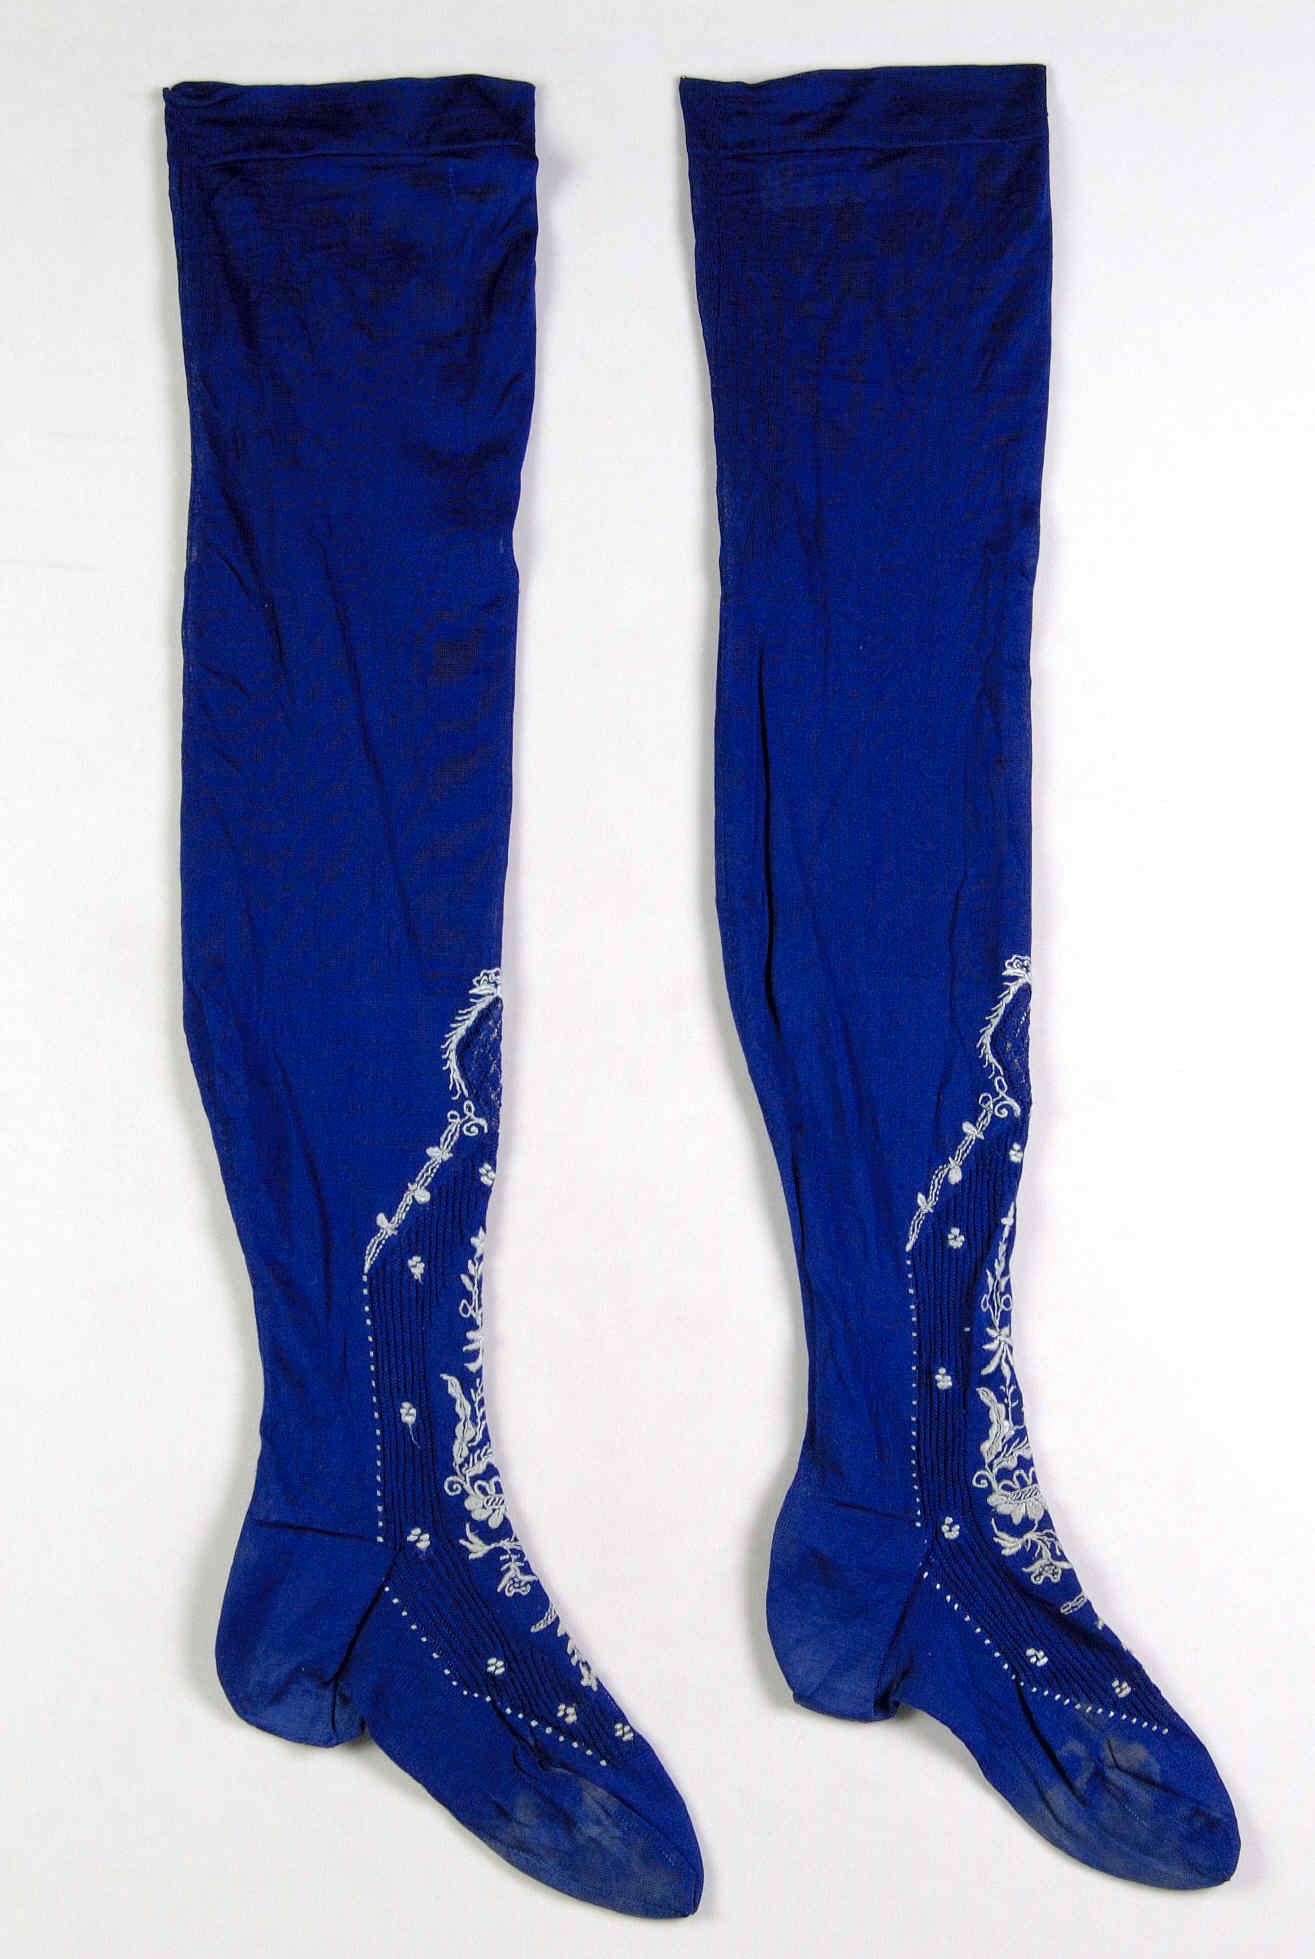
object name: stocking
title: Stockings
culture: american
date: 1890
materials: silk